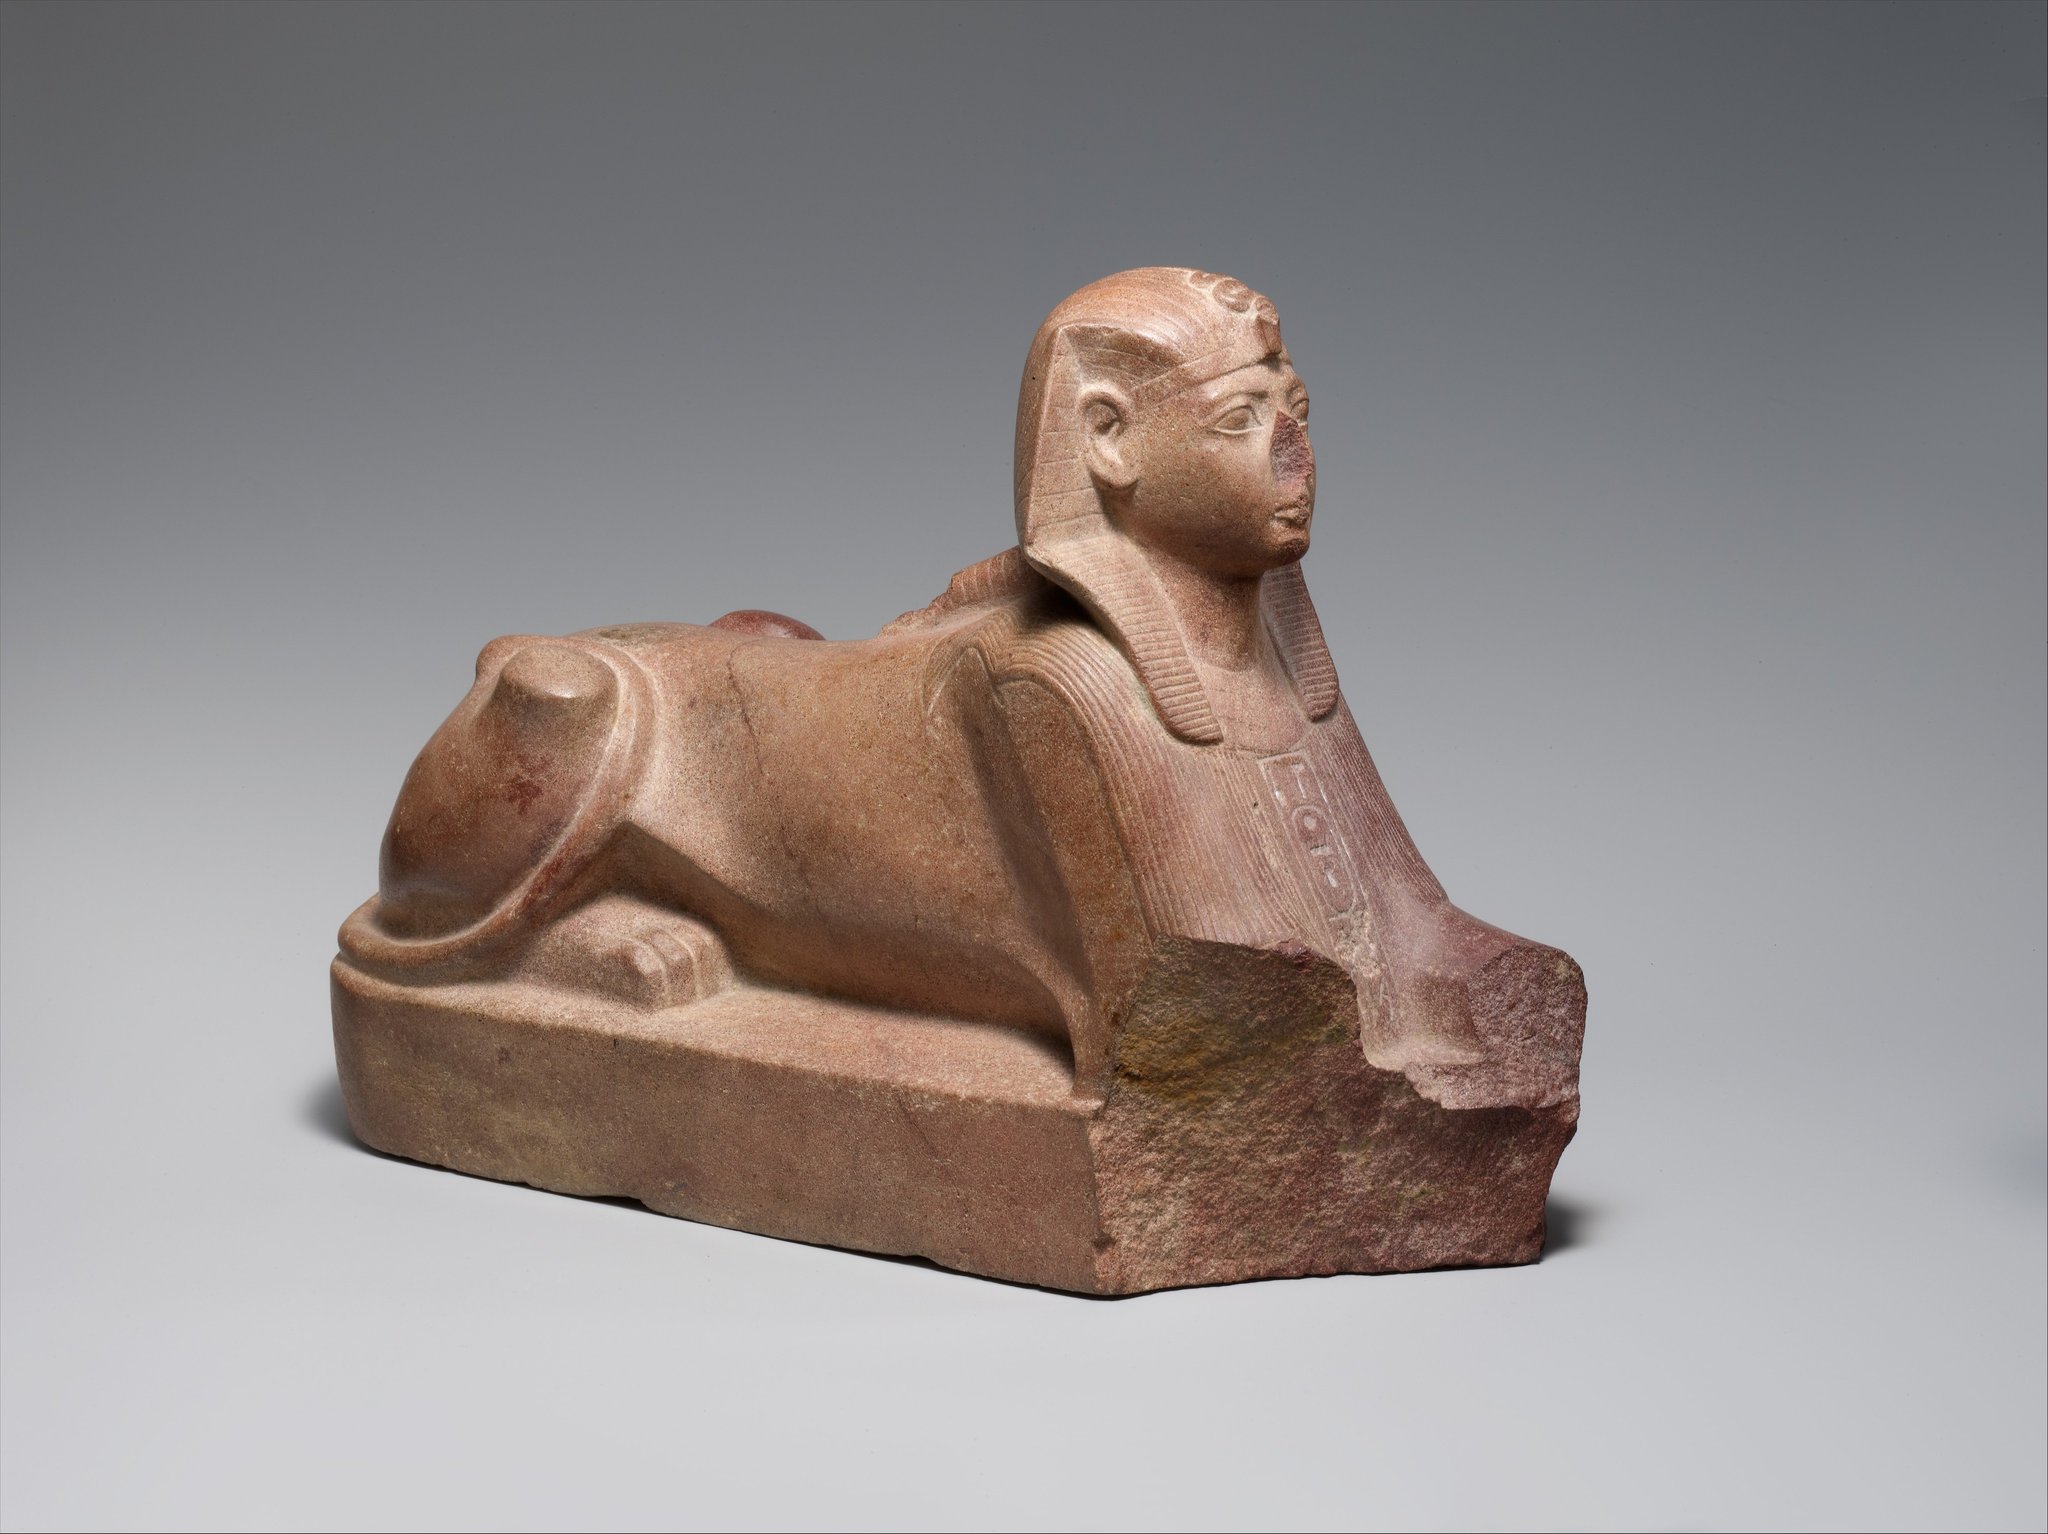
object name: sphinx, thutmose iii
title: Sphinx of Thutmose III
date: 1479-1425 BCE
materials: quartzite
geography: egypt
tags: sphinx